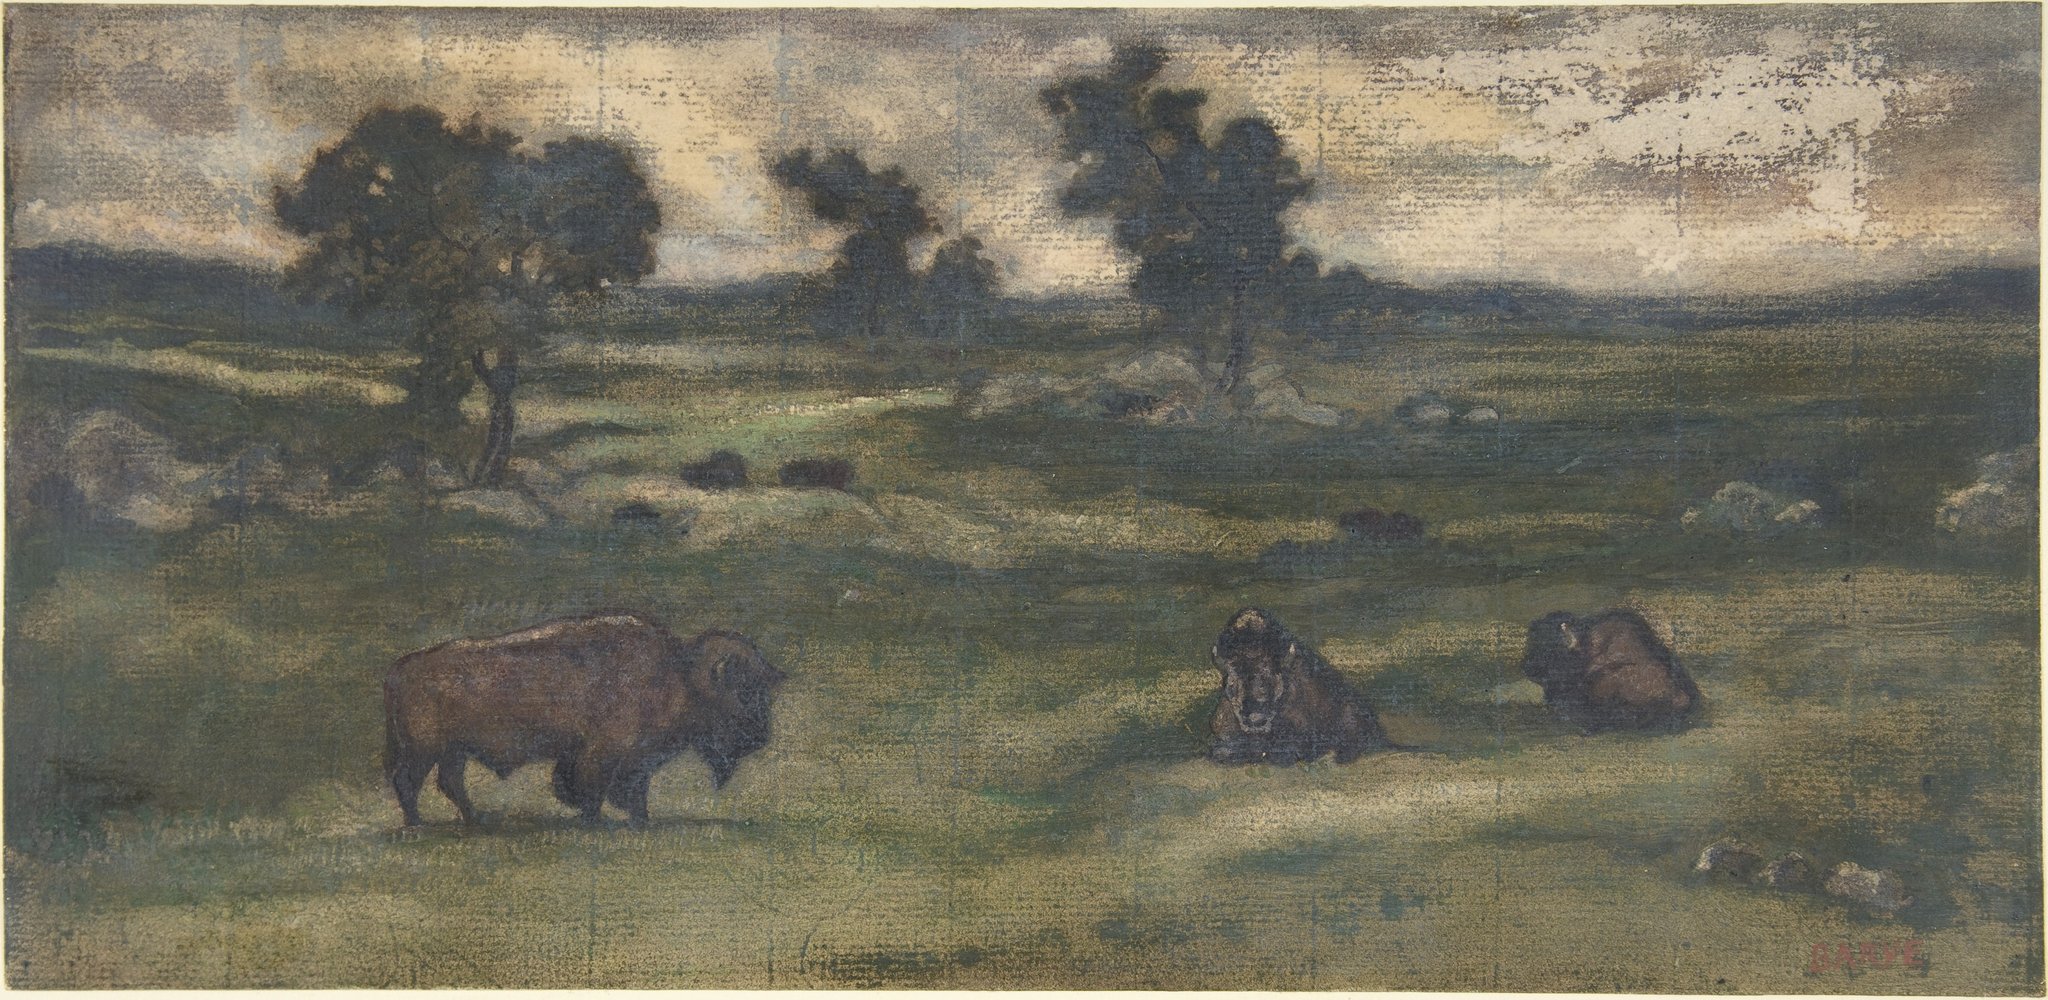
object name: drawing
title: Group of Bison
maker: antoine-louis barye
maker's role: artist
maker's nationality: french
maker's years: 1795-1875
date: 1810-1875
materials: paper, watercolor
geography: france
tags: animals